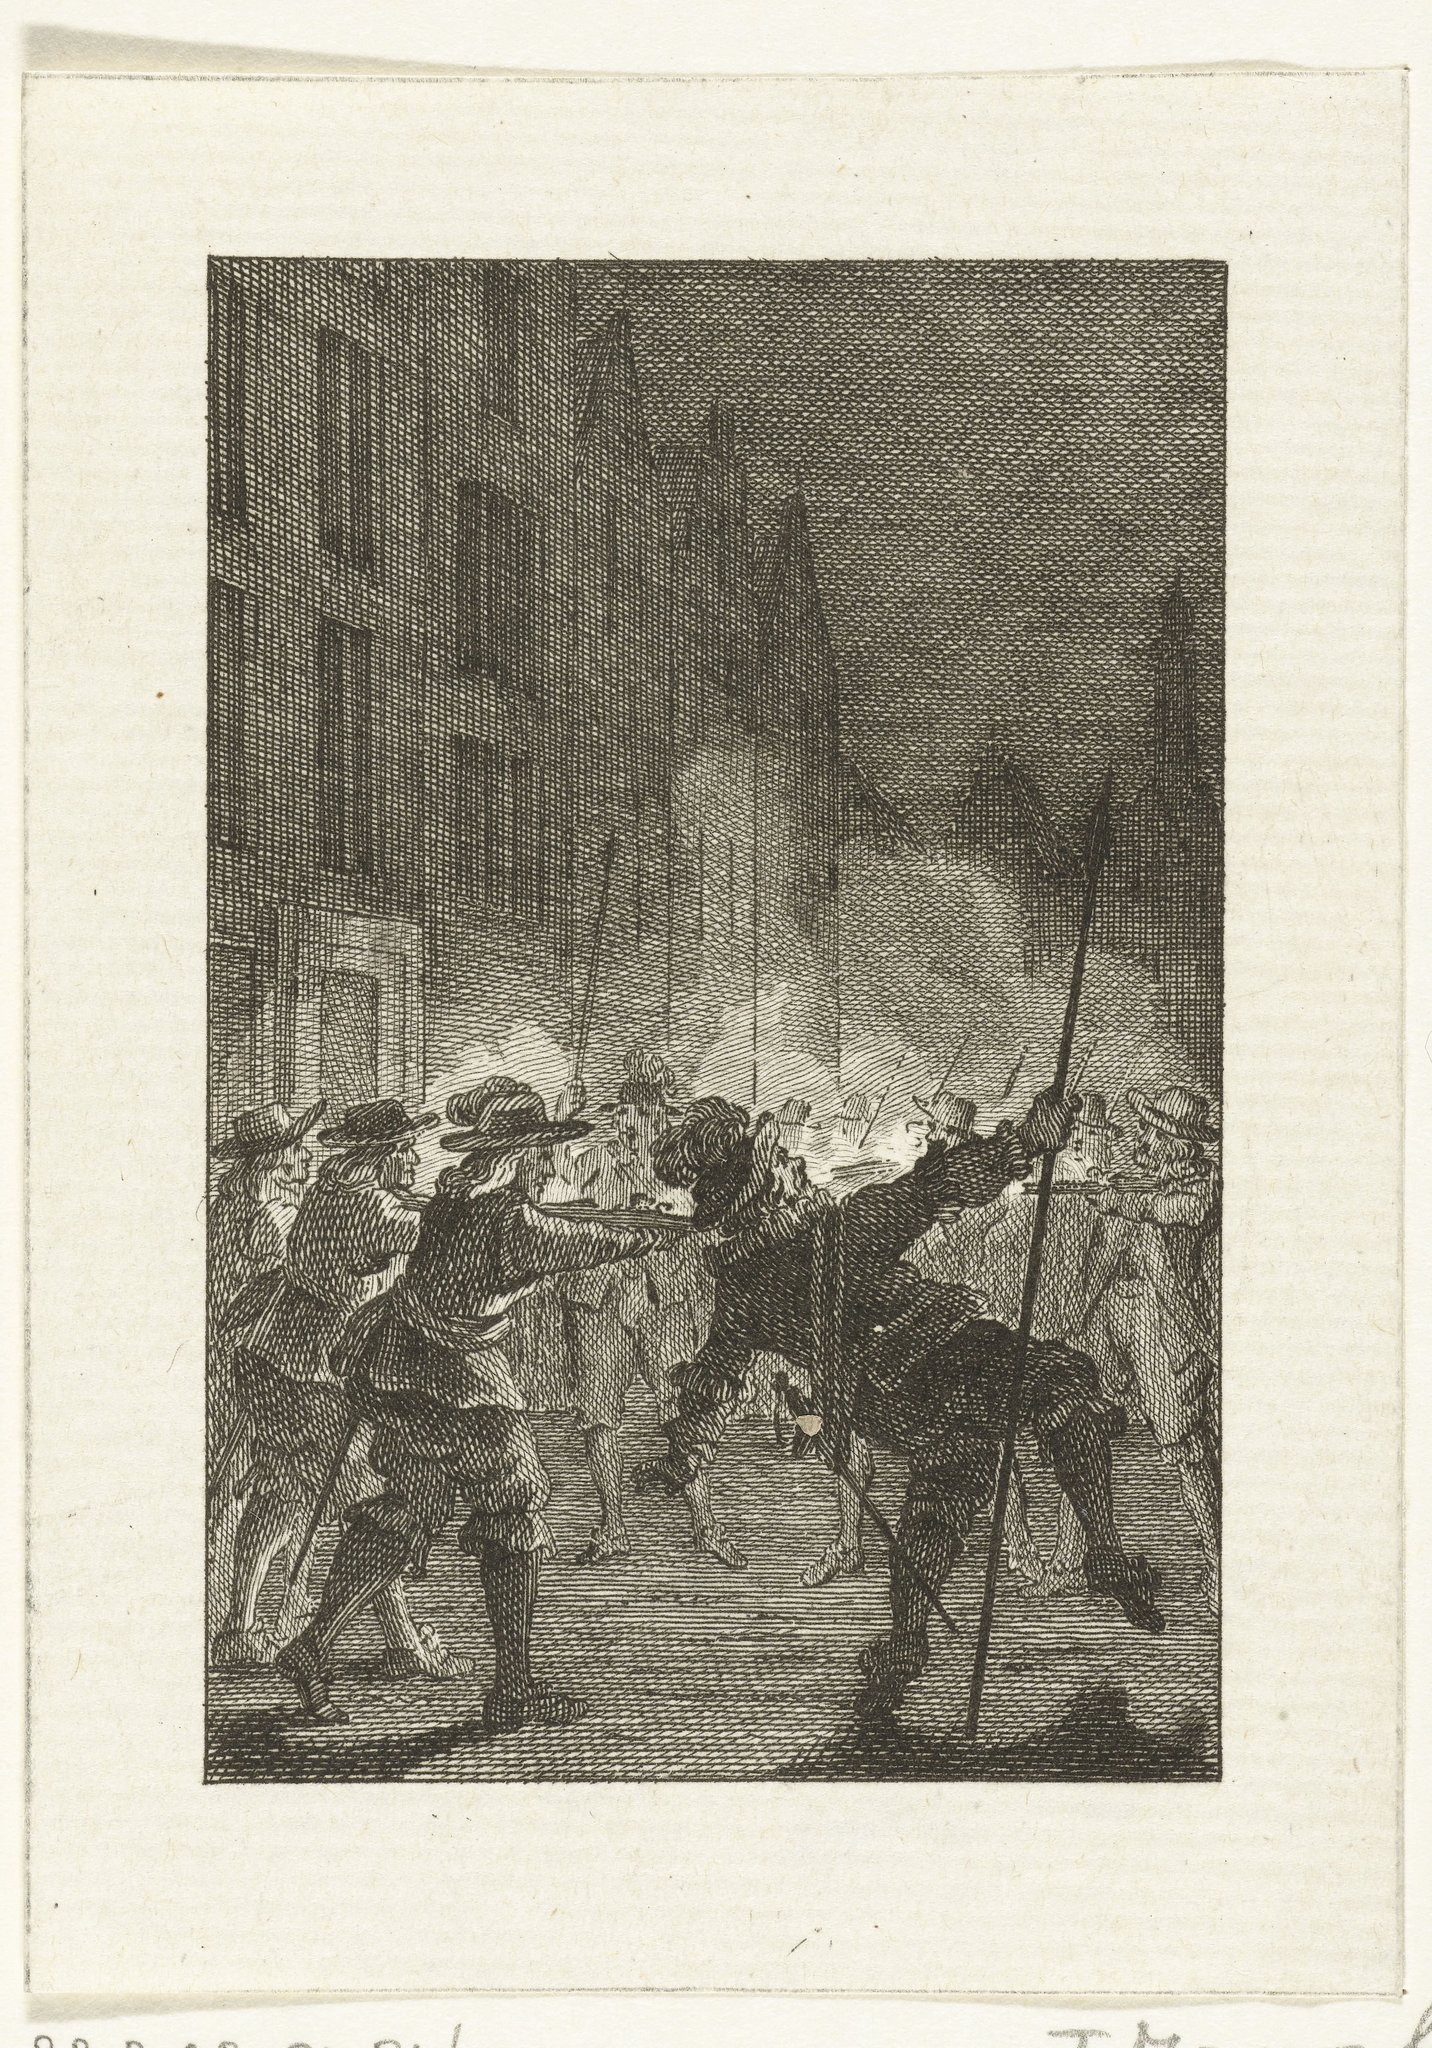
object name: history print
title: Gillis van der Misse gedood te Goes, 1657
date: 1780-1795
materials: paper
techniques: etching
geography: netherlands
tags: violent death, being killed; being mishandled and maltreated; seeking death, street-fights, riots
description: Gillis van der Misse gedood te Goes bij een poging het oproer op straat over de verkiezing van rentmeesters te stillen, maart 1657. Van der Misse wordt geraakt tijdens een vuurgevecht op straat.